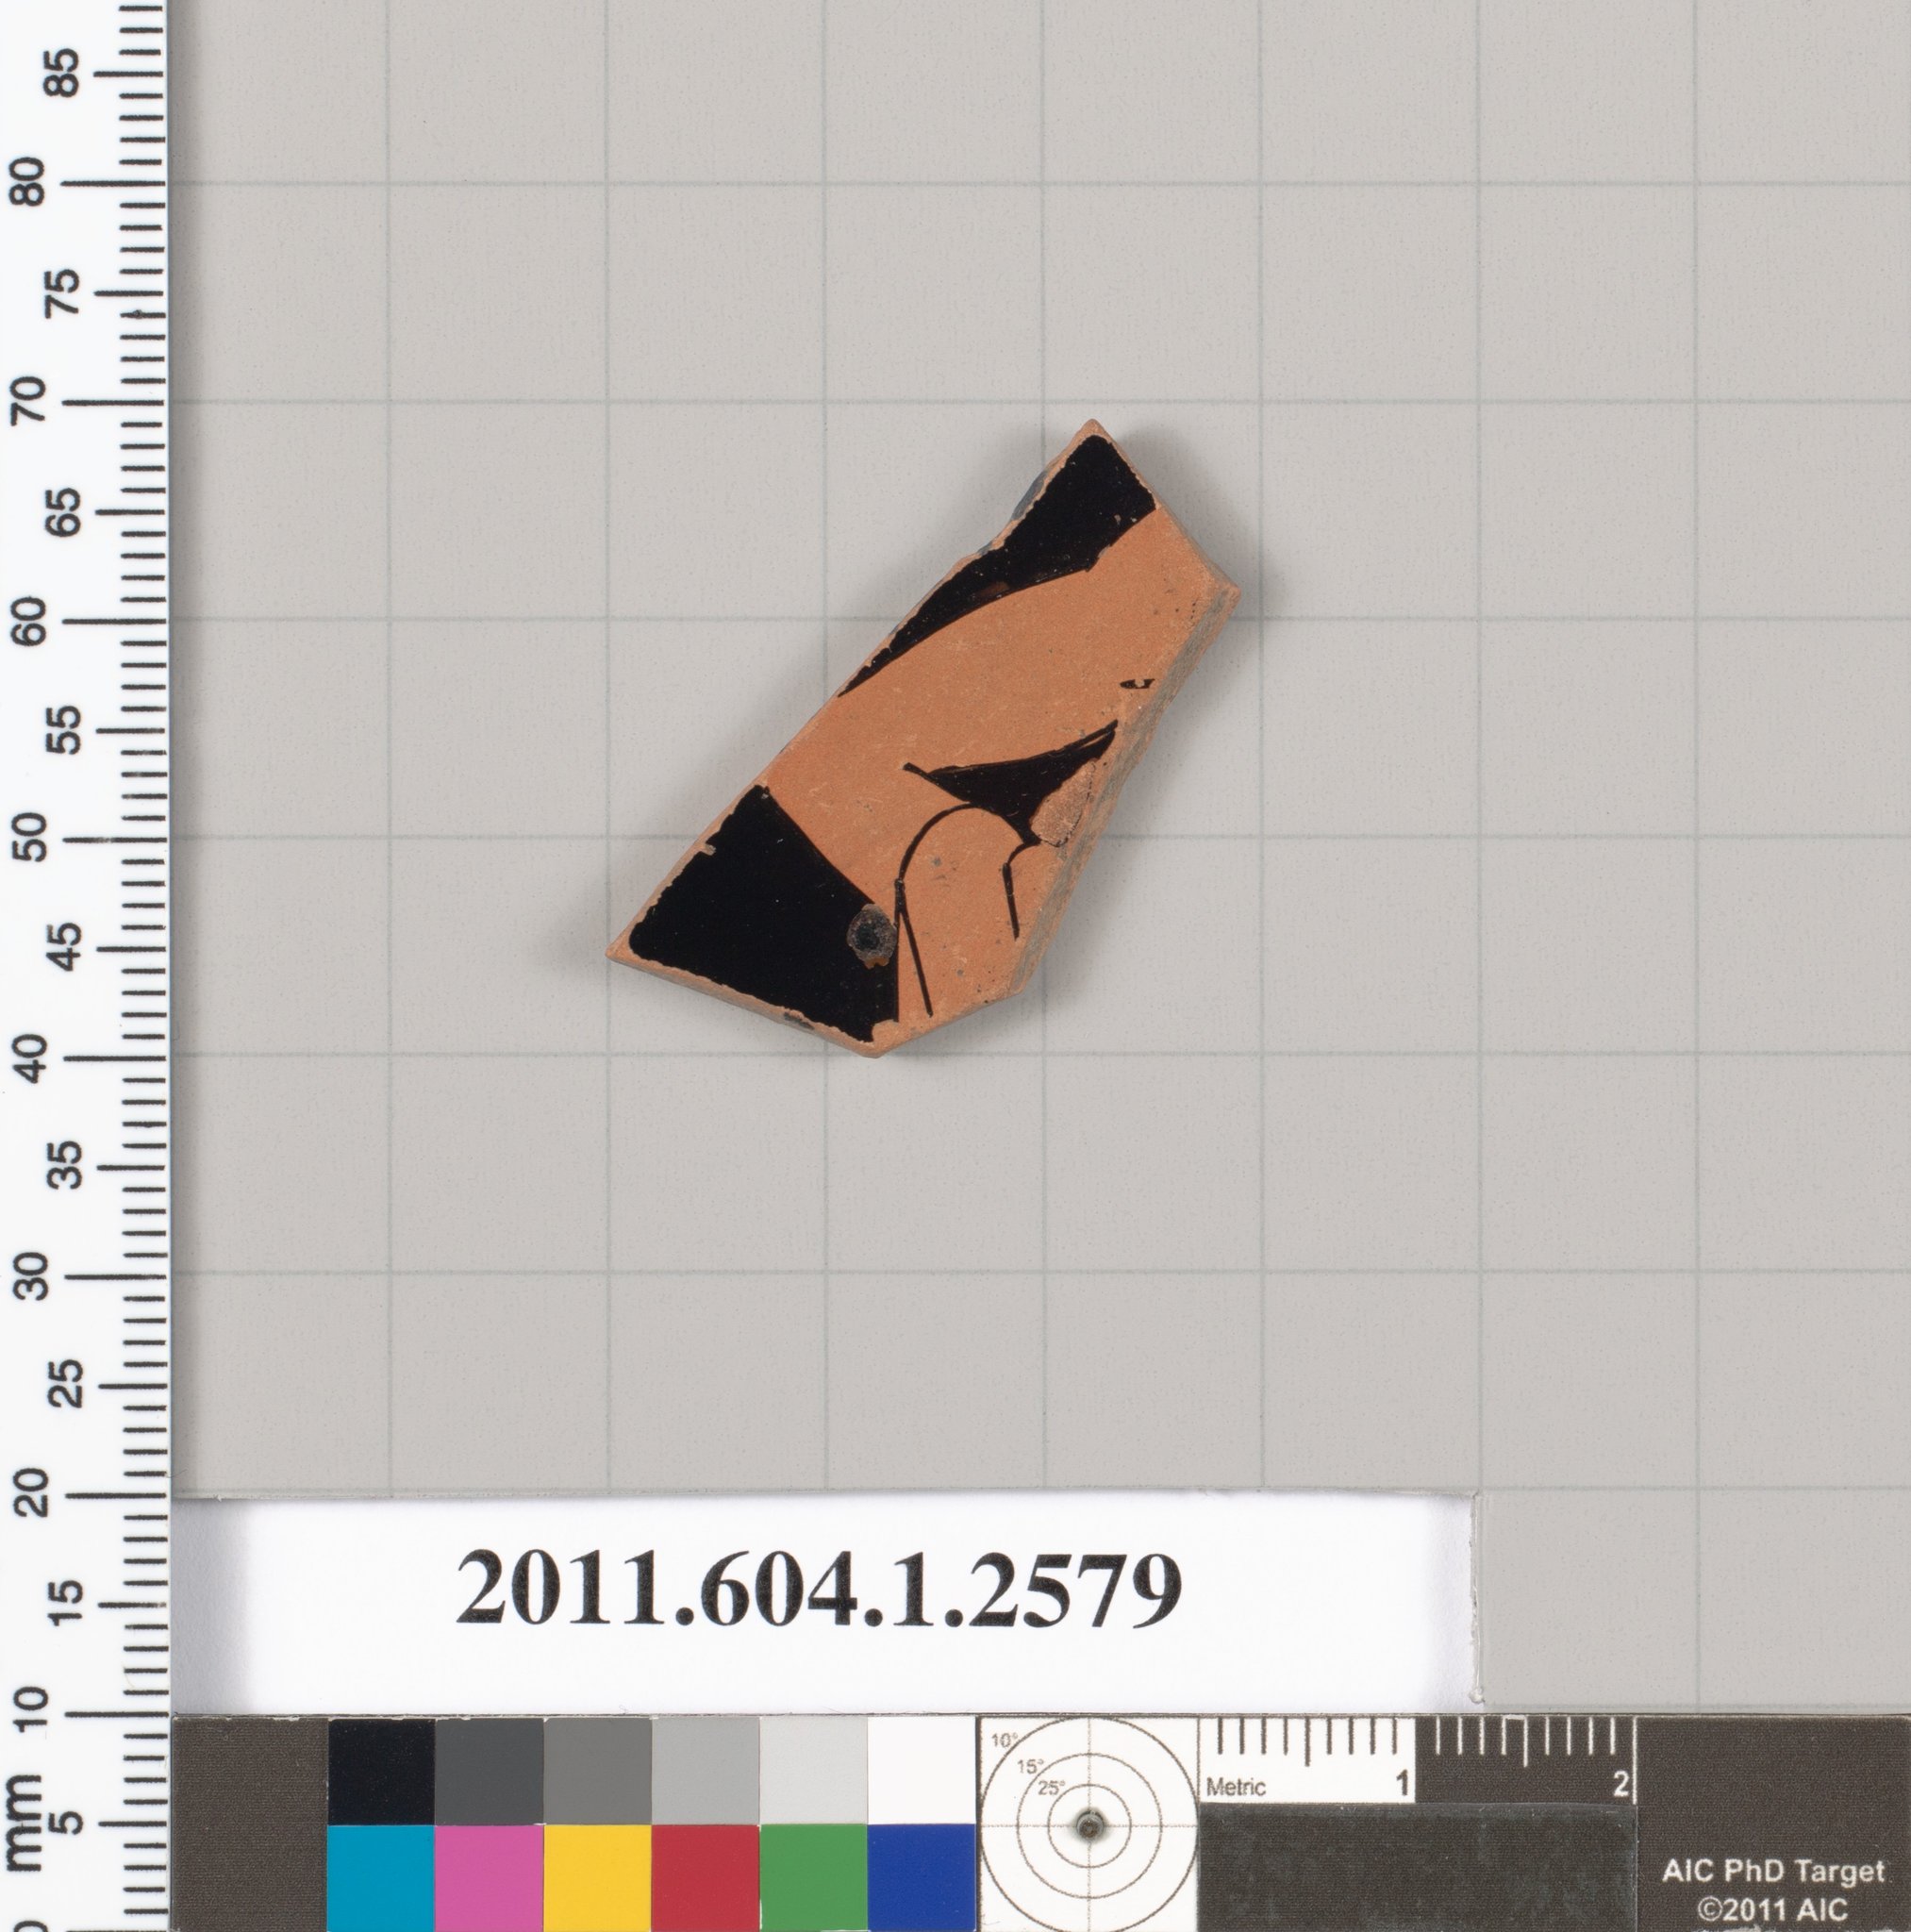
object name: kylix fragment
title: Terracotta fragment of a kylix (drinking cup)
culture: greek, attic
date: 490-480 BCE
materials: terracotta